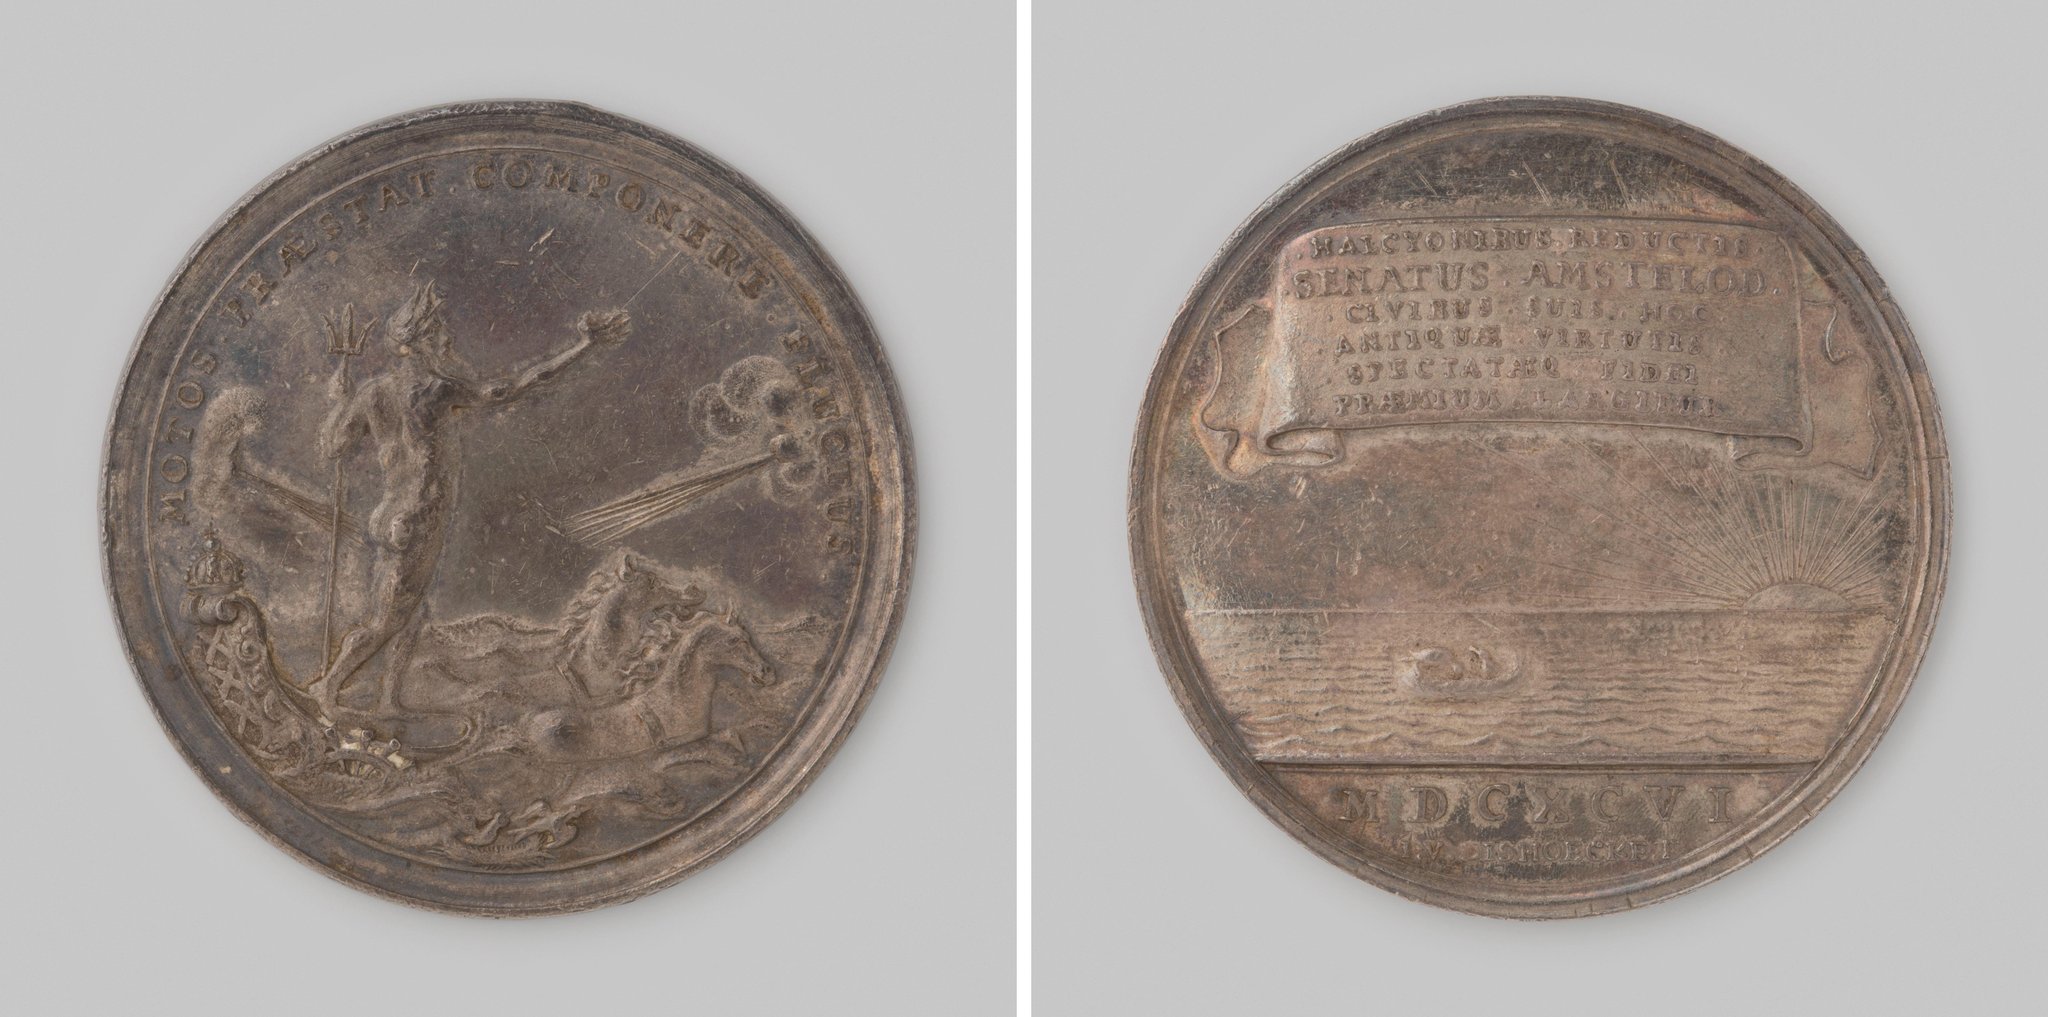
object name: history medal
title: Beloningspenning voor het neerslaan van het aansprekersoproer in Amsterdam 1696 (groot model)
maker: jacob van dishoecke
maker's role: silversmith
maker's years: 1650-1723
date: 1696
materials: silver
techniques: striking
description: Zilveren penning, op de voorzijde Neptunus in strijdwagen op zee tussen twee windgoden, met omschrift, op de keerzijde een vredige zee waarop een vogelnest, met bovenaan een tekstvlag en in afsnede XDCXCVI / I. V. DISHOECKE. F